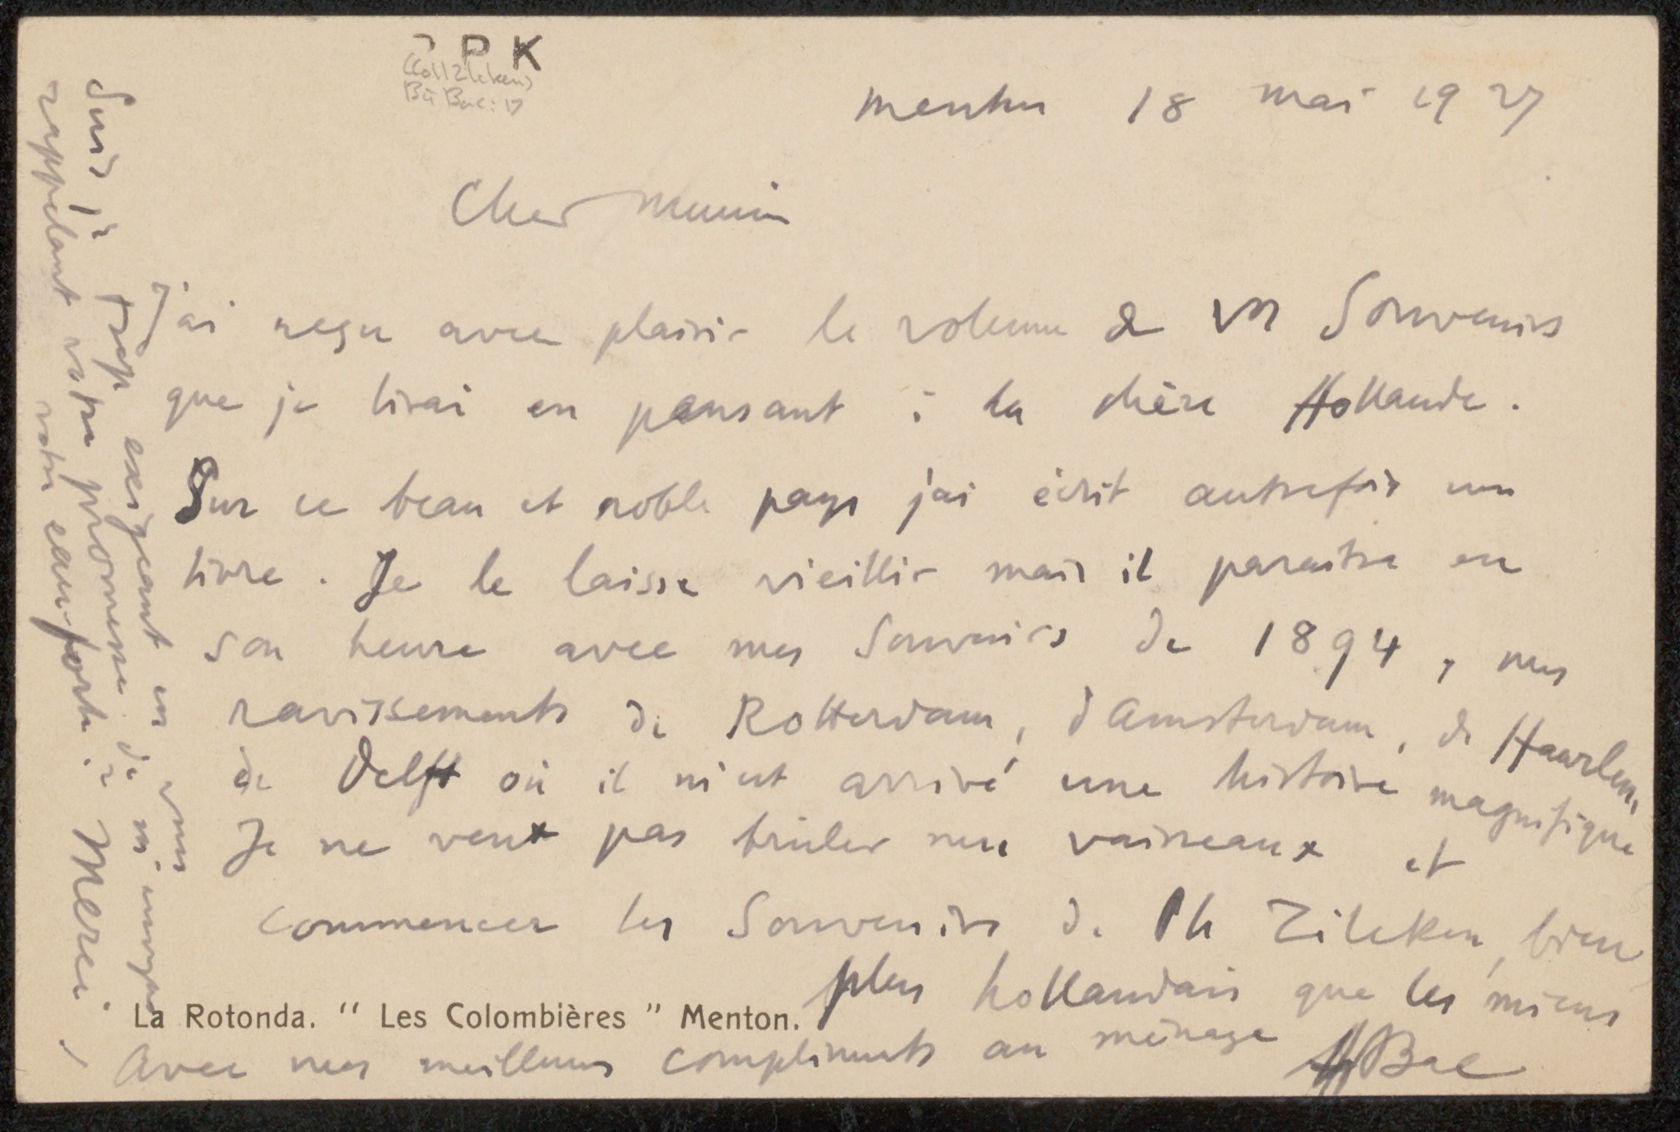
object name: letter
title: Brief aan onbekend persoon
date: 1927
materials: ink, paper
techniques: pen, writing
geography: the hague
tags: ferdinand-sigismund bac, painter, draughtsman, philip zilcken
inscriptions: collector's mark: ‘RPK’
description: De brief is bewaard bij correspondentie van Ferdinand-Sigismund Bac aan Philip Zilcken.